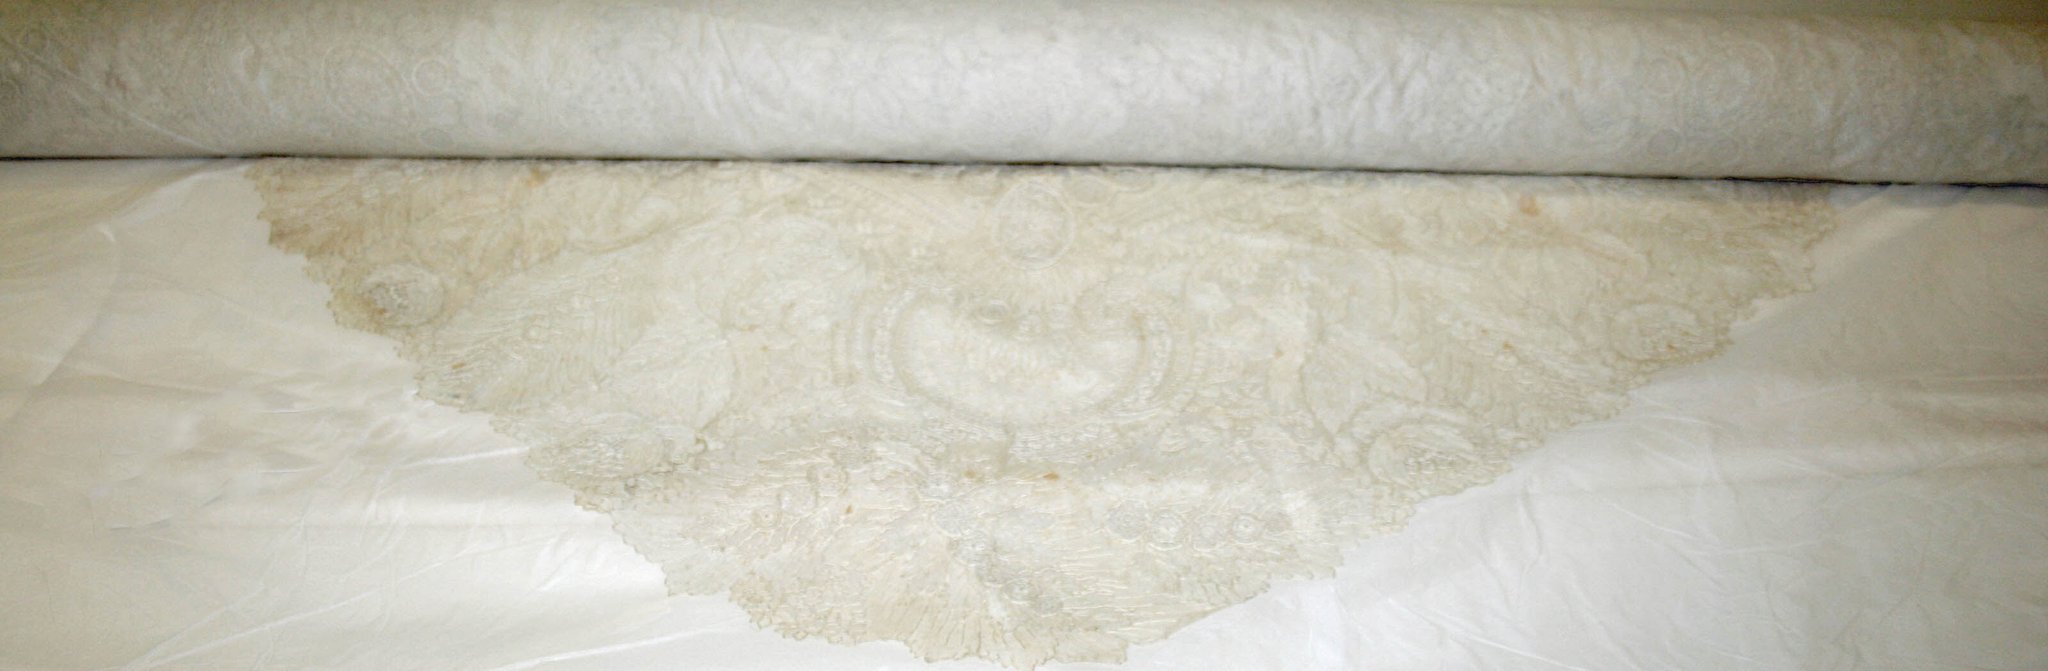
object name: wedding veil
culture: belgian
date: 1880-1889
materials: linen